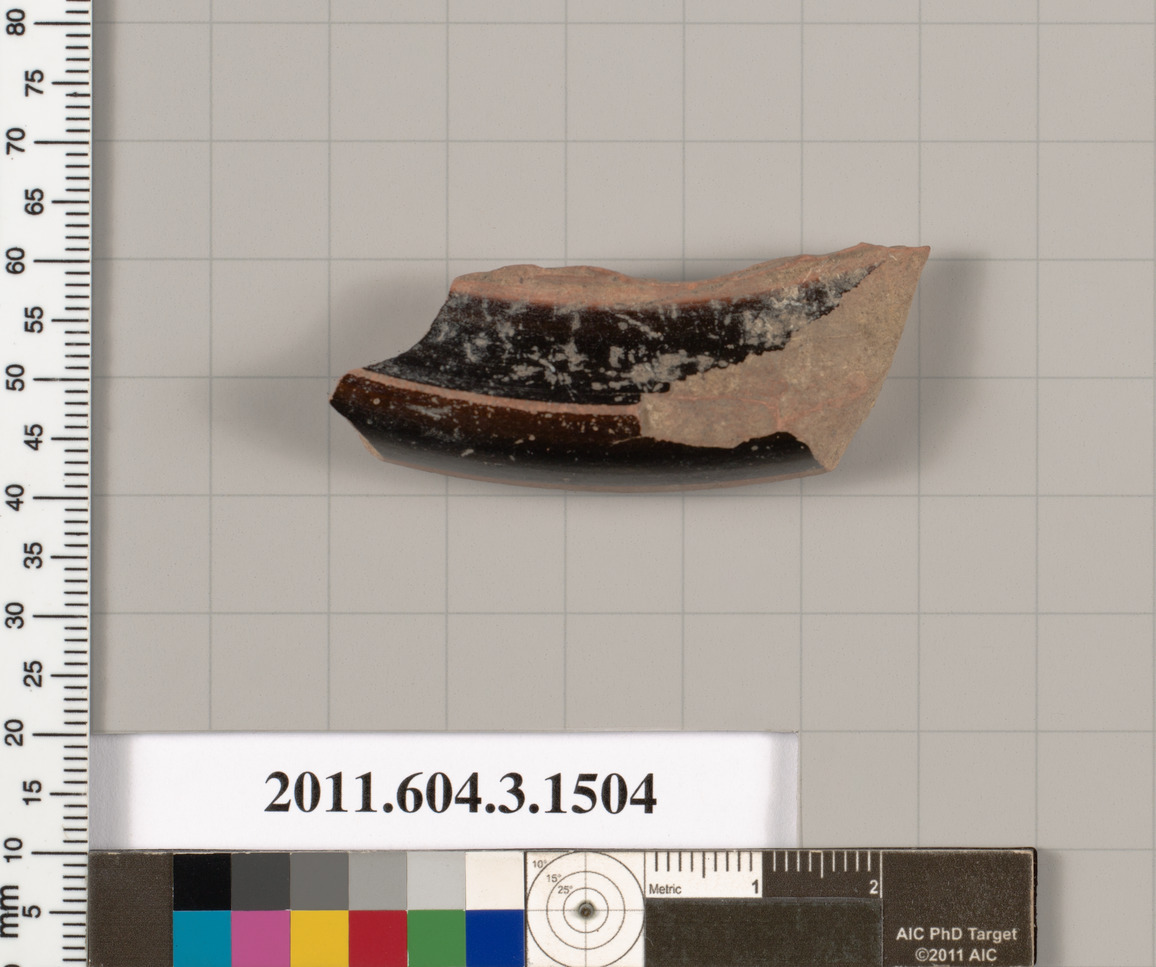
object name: skyphos fragment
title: Terracotta fragment of a skyphos (deep drinking cup)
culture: greek, attic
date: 600-401 BCE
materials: terracotta